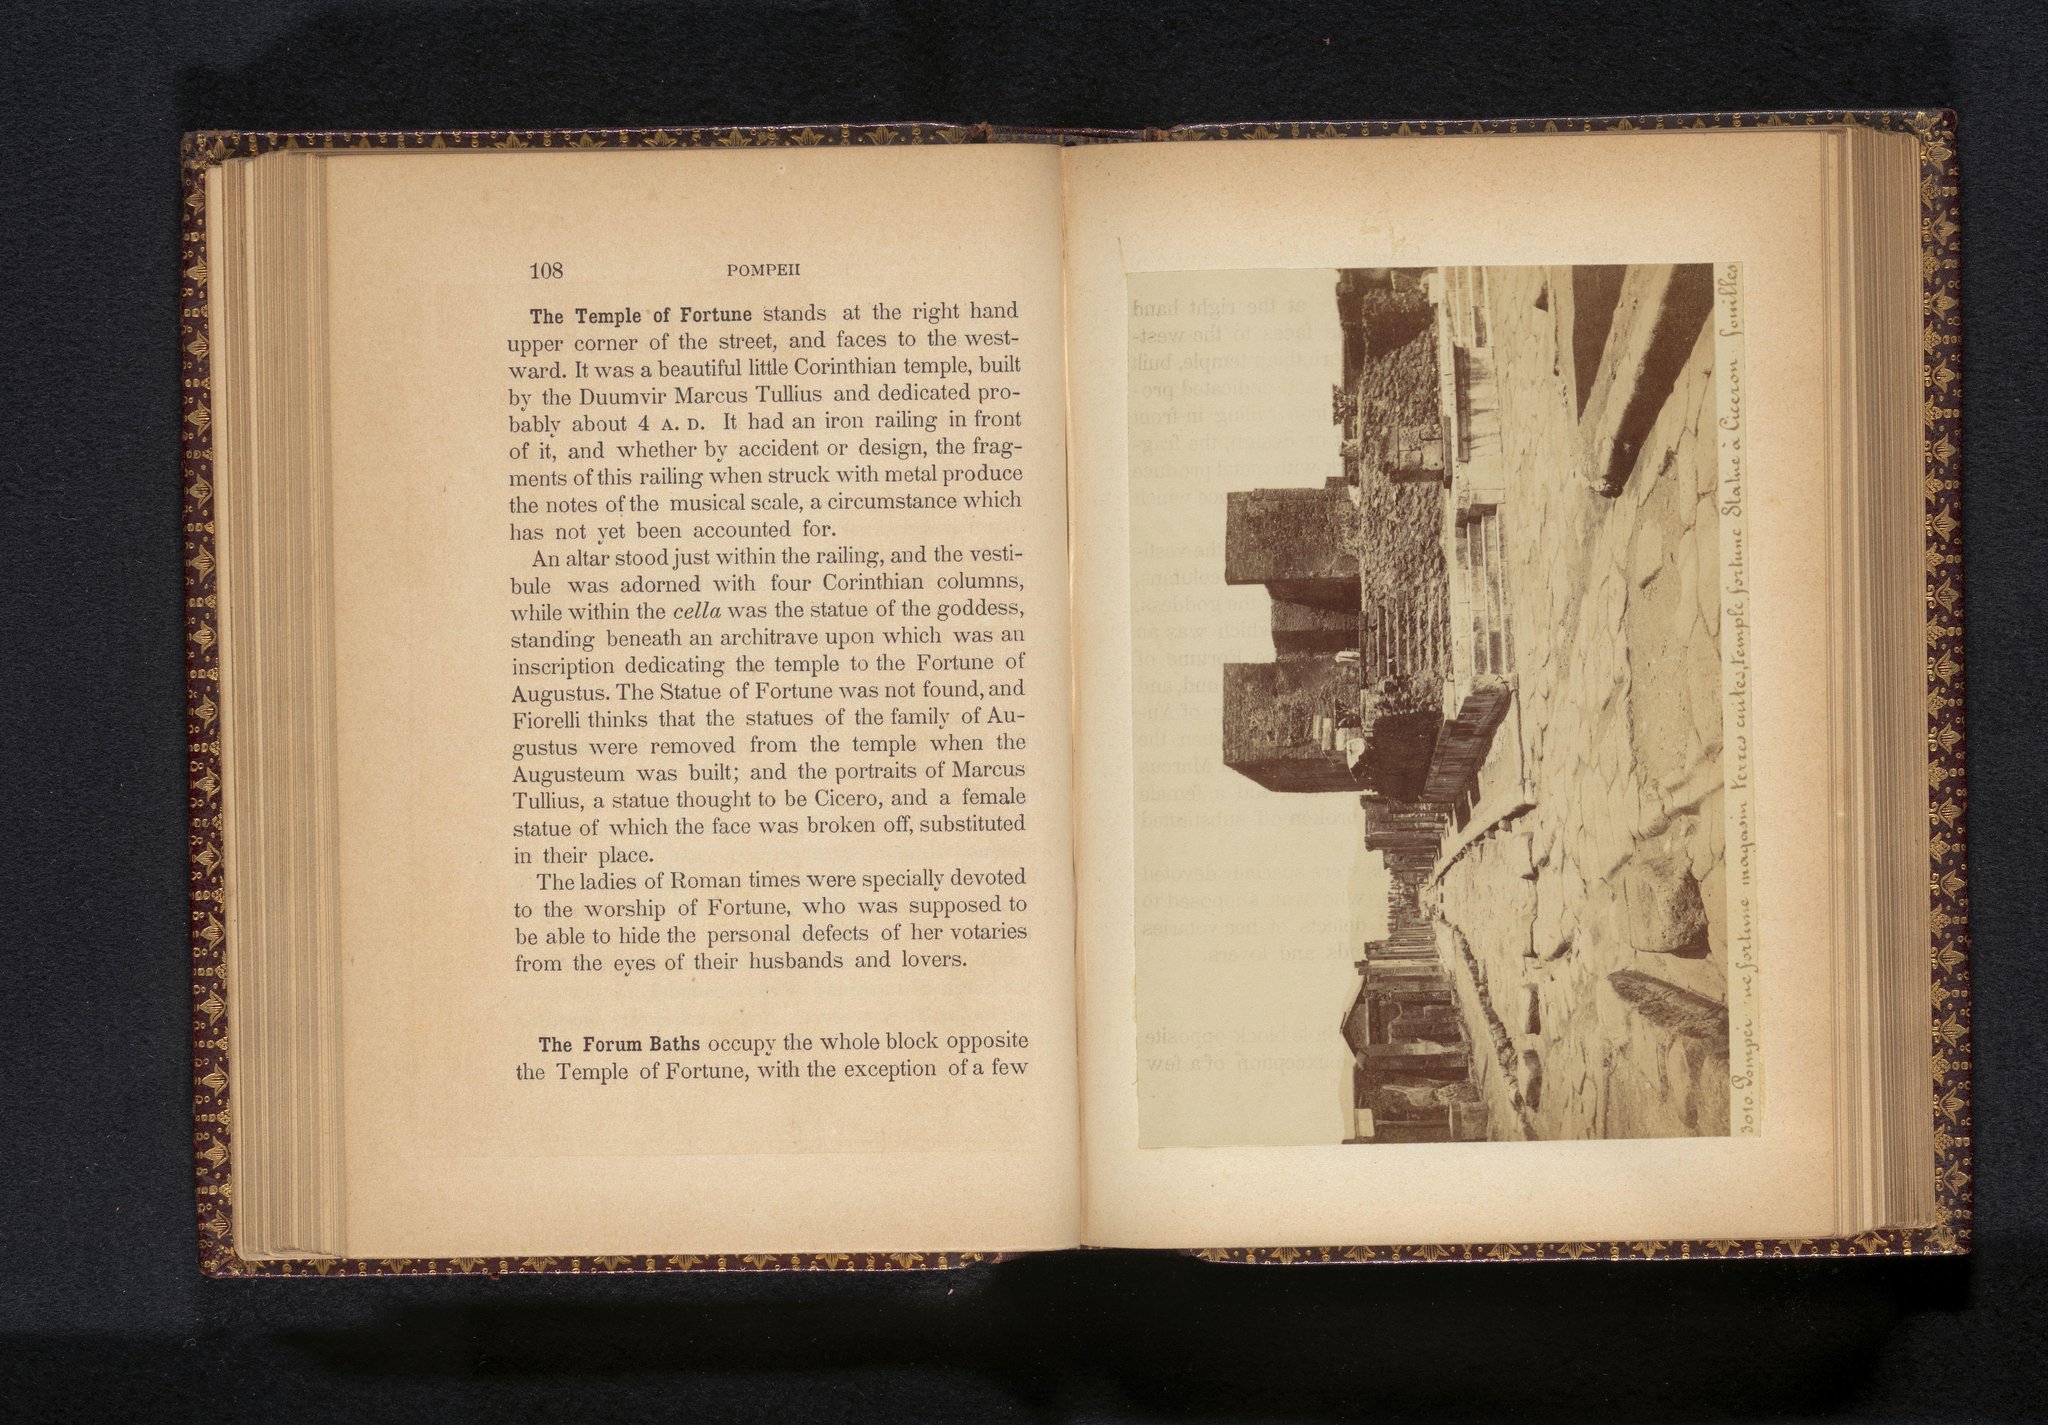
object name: page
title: Gezicht op de ruïne van de Tempio della Fortuna Augusta te Pompeï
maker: Anonymous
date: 1878-1888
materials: photographic support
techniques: albumen print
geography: pompeii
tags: landscape with ruins, temple, shrine ~ roman religion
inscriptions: number: ‘3010’